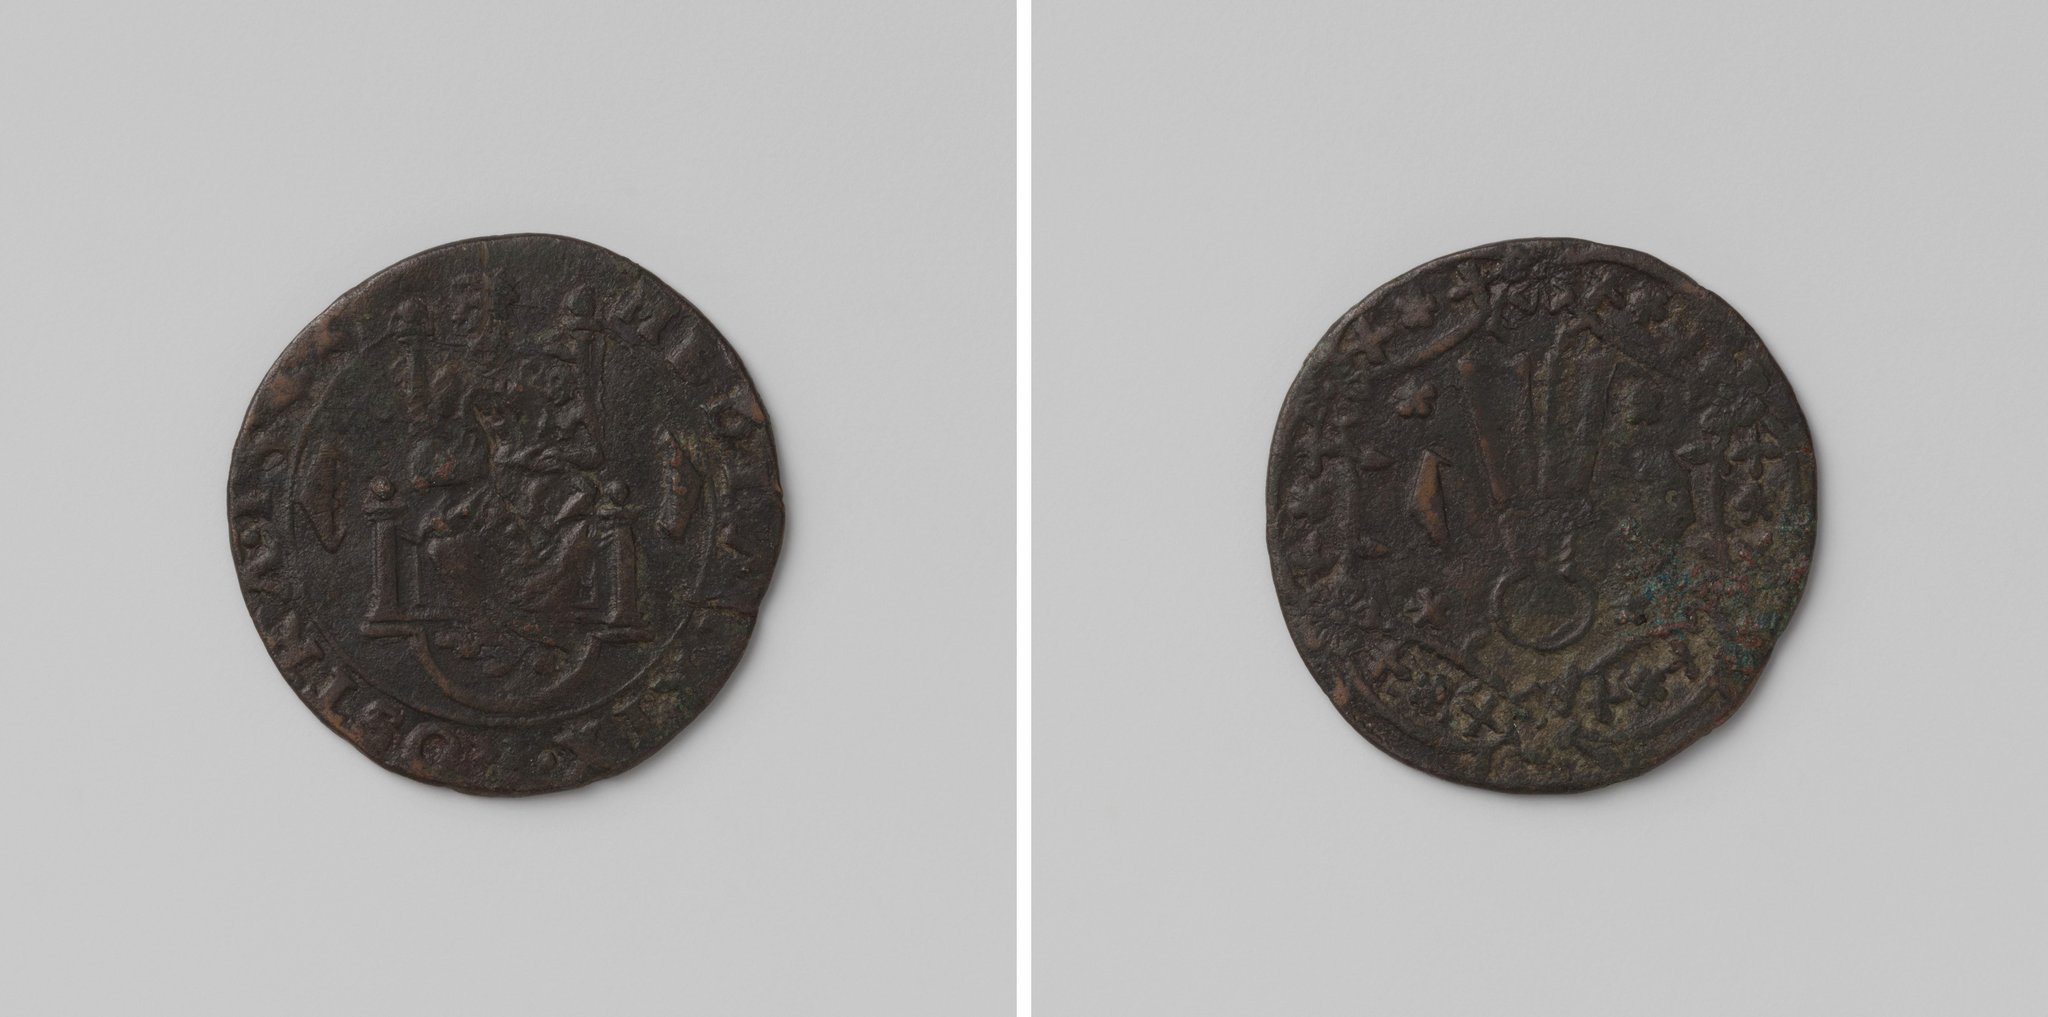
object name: medal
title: Droogscheerdersgilde van Antwerpen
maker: Anonymous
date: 1545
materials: copper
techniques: striking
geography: antwerp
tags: antwerp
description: Koperen penning. Voorzijde: vrouw met kind op arm, zittend op zetel tussen twee langwerpige, driehoekige voorwerpen binnen omschrift. Keerzijde: droogscheerdersschaar tussen kam en langwerpig driehoekig voorwerp binnen krans van bladeren en bloemen